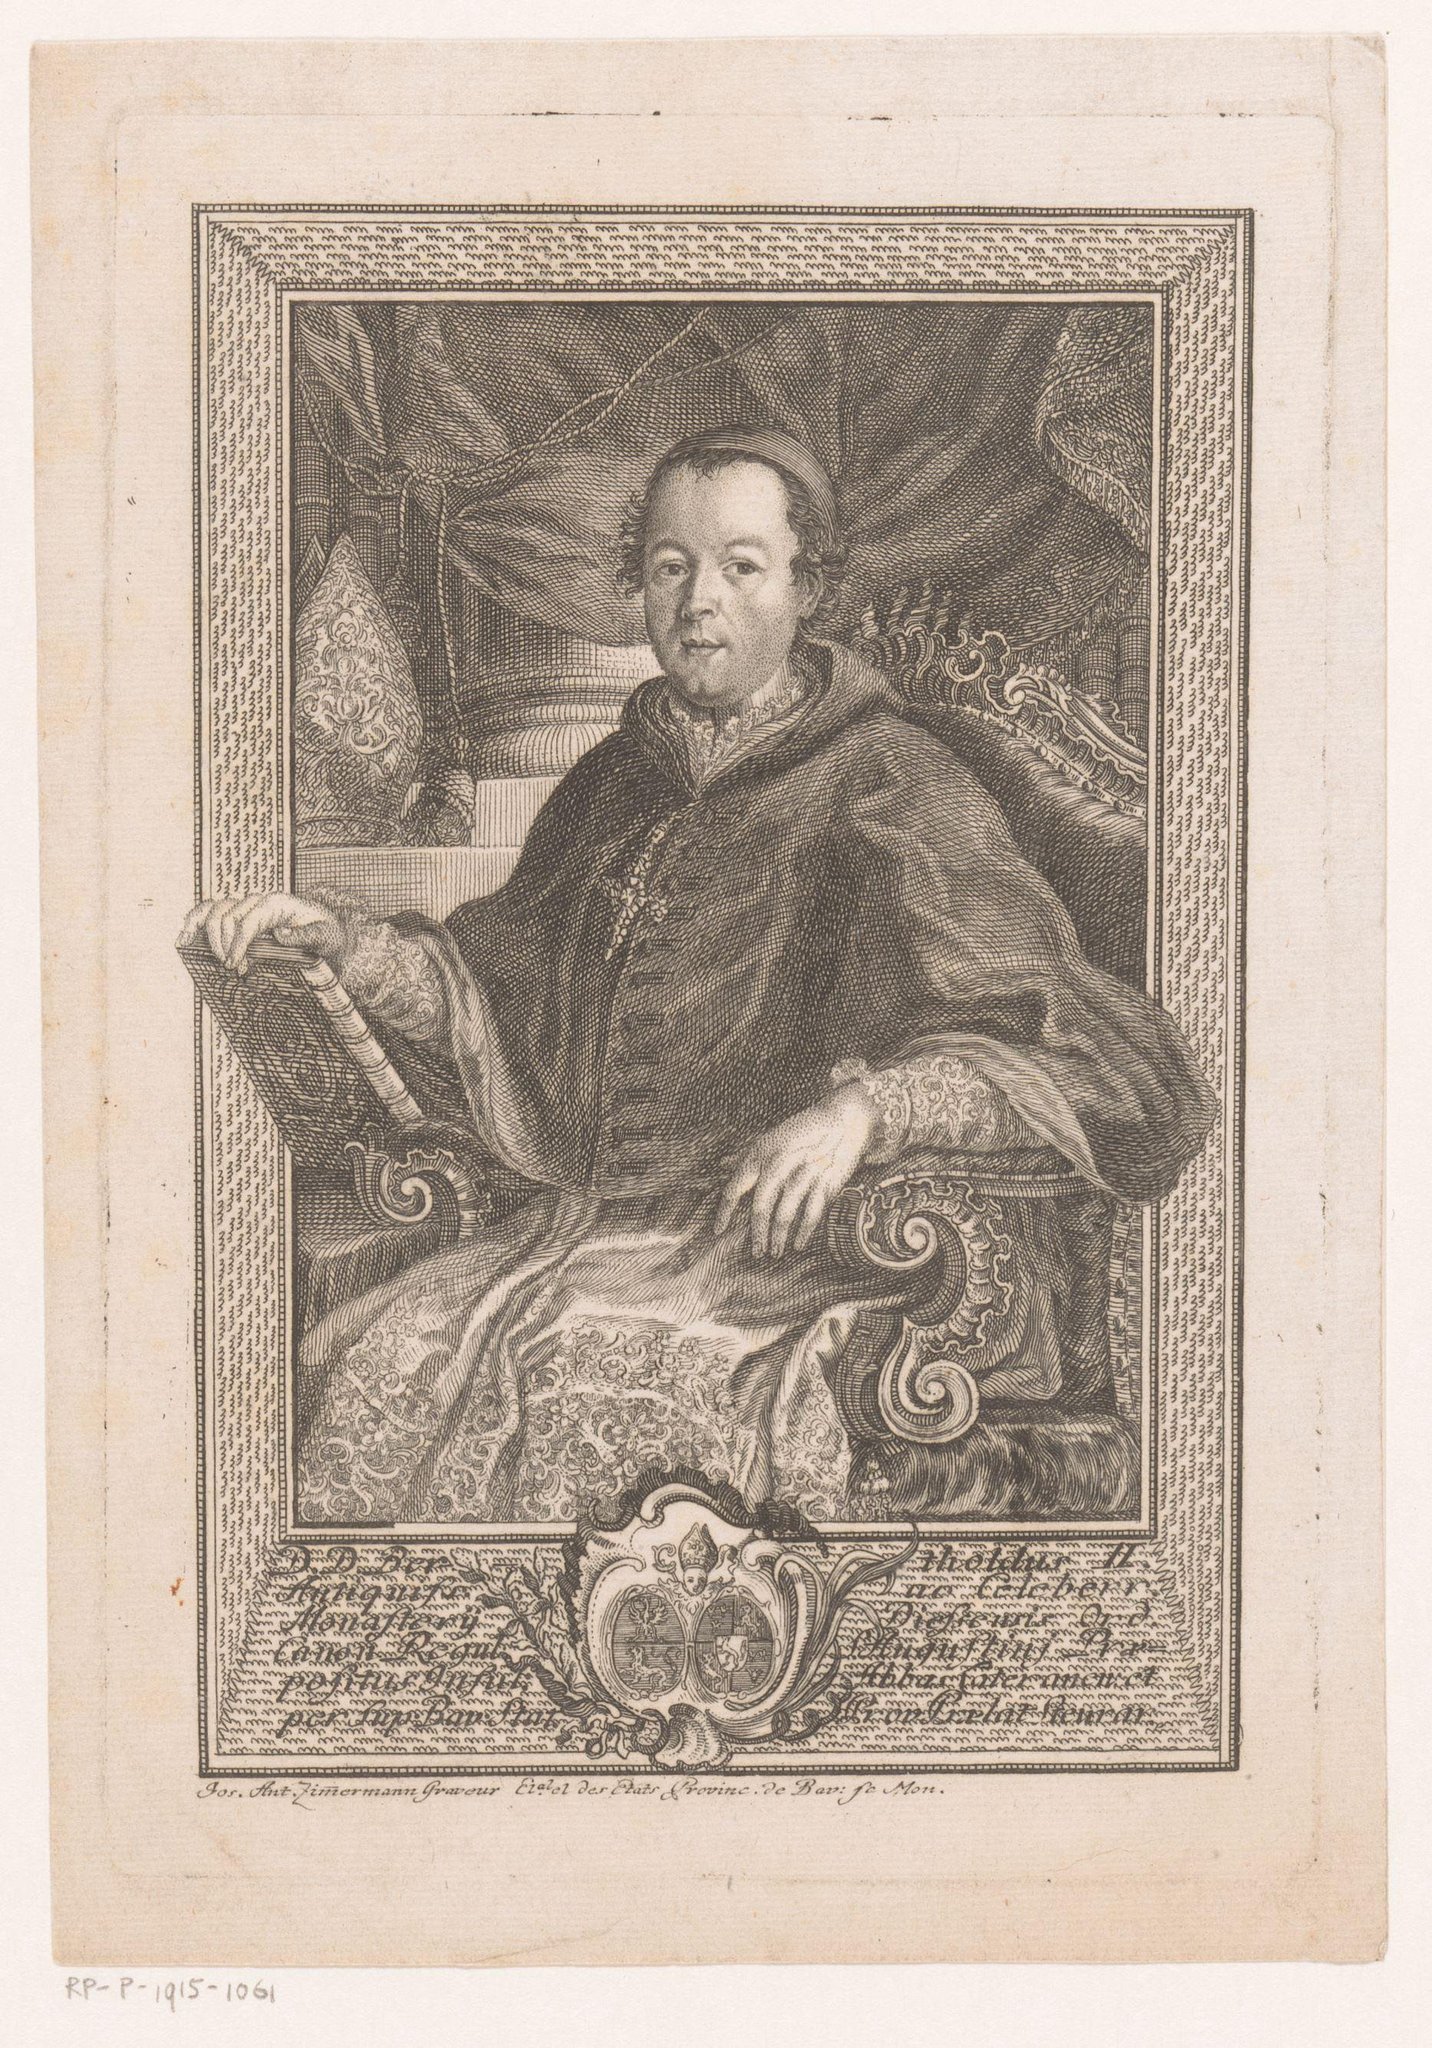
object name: print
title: Portret van Bertholdus II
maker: joseph anton zimmermann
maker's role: draughtsman, print maker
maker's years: 1705-1797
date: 1715-1797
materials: paper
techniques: engraving, etching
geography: munich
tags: historical persons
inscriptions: collector's mark: Lugt 2228